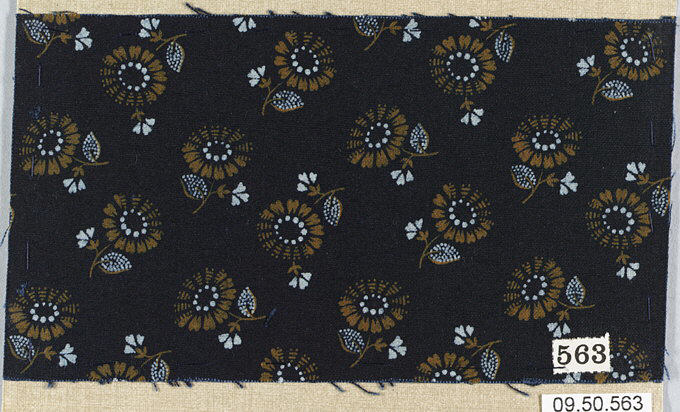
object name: piece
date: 1801-1900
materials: cotton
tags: flowers,leaves